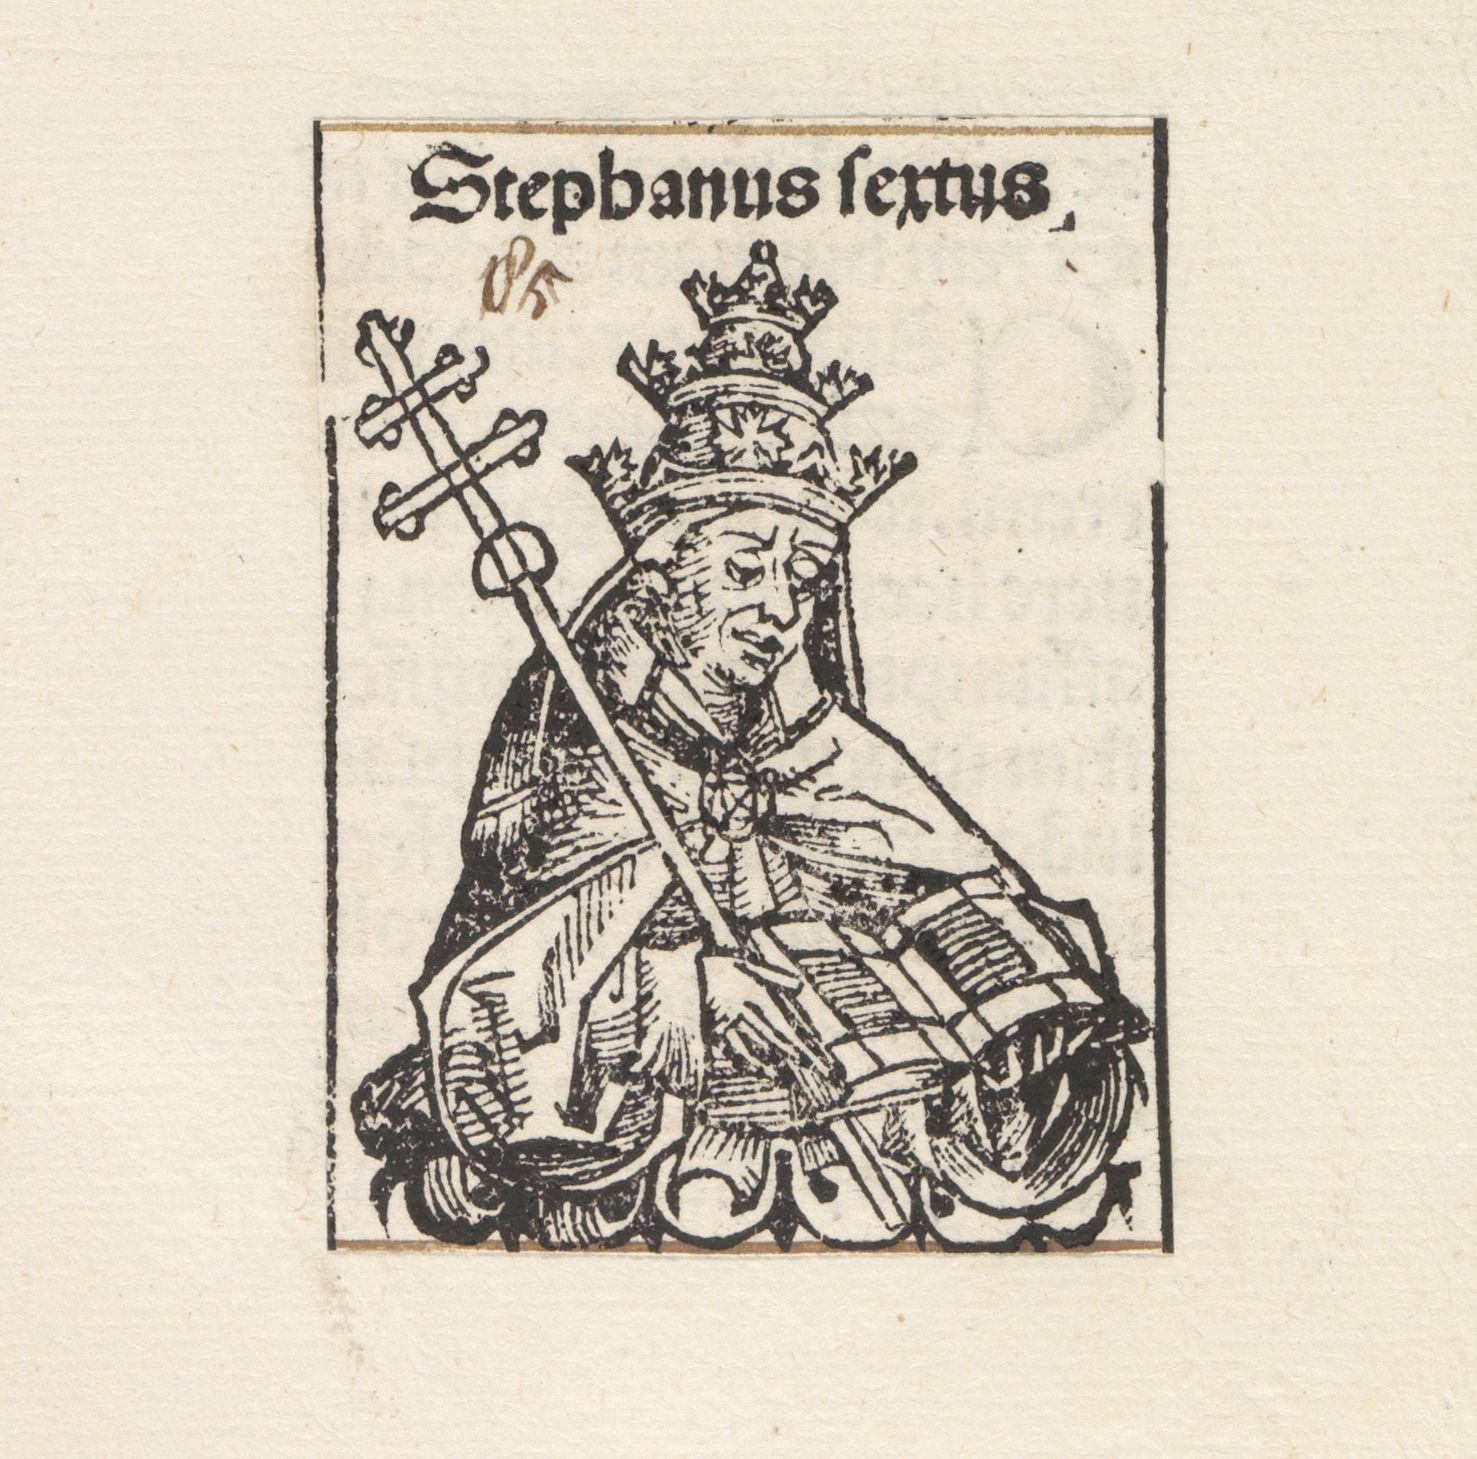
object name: print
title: Stefanus VI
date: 1493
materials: paper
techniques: letterpress printing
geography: nuremberg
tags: pope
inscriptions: inscription: ‘85’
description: Een bloemkelk met een paus. Hij draagt een tiara en heeft een opengeslagen boek en een staf met een dubbel kruis in zijn handen. De voorstelling is onderdeel van de opeenvolging pausen in de Liber Chronicarum. De tekst identificeert de man als Stefanus VI. De prent maakt deel uit van een album.